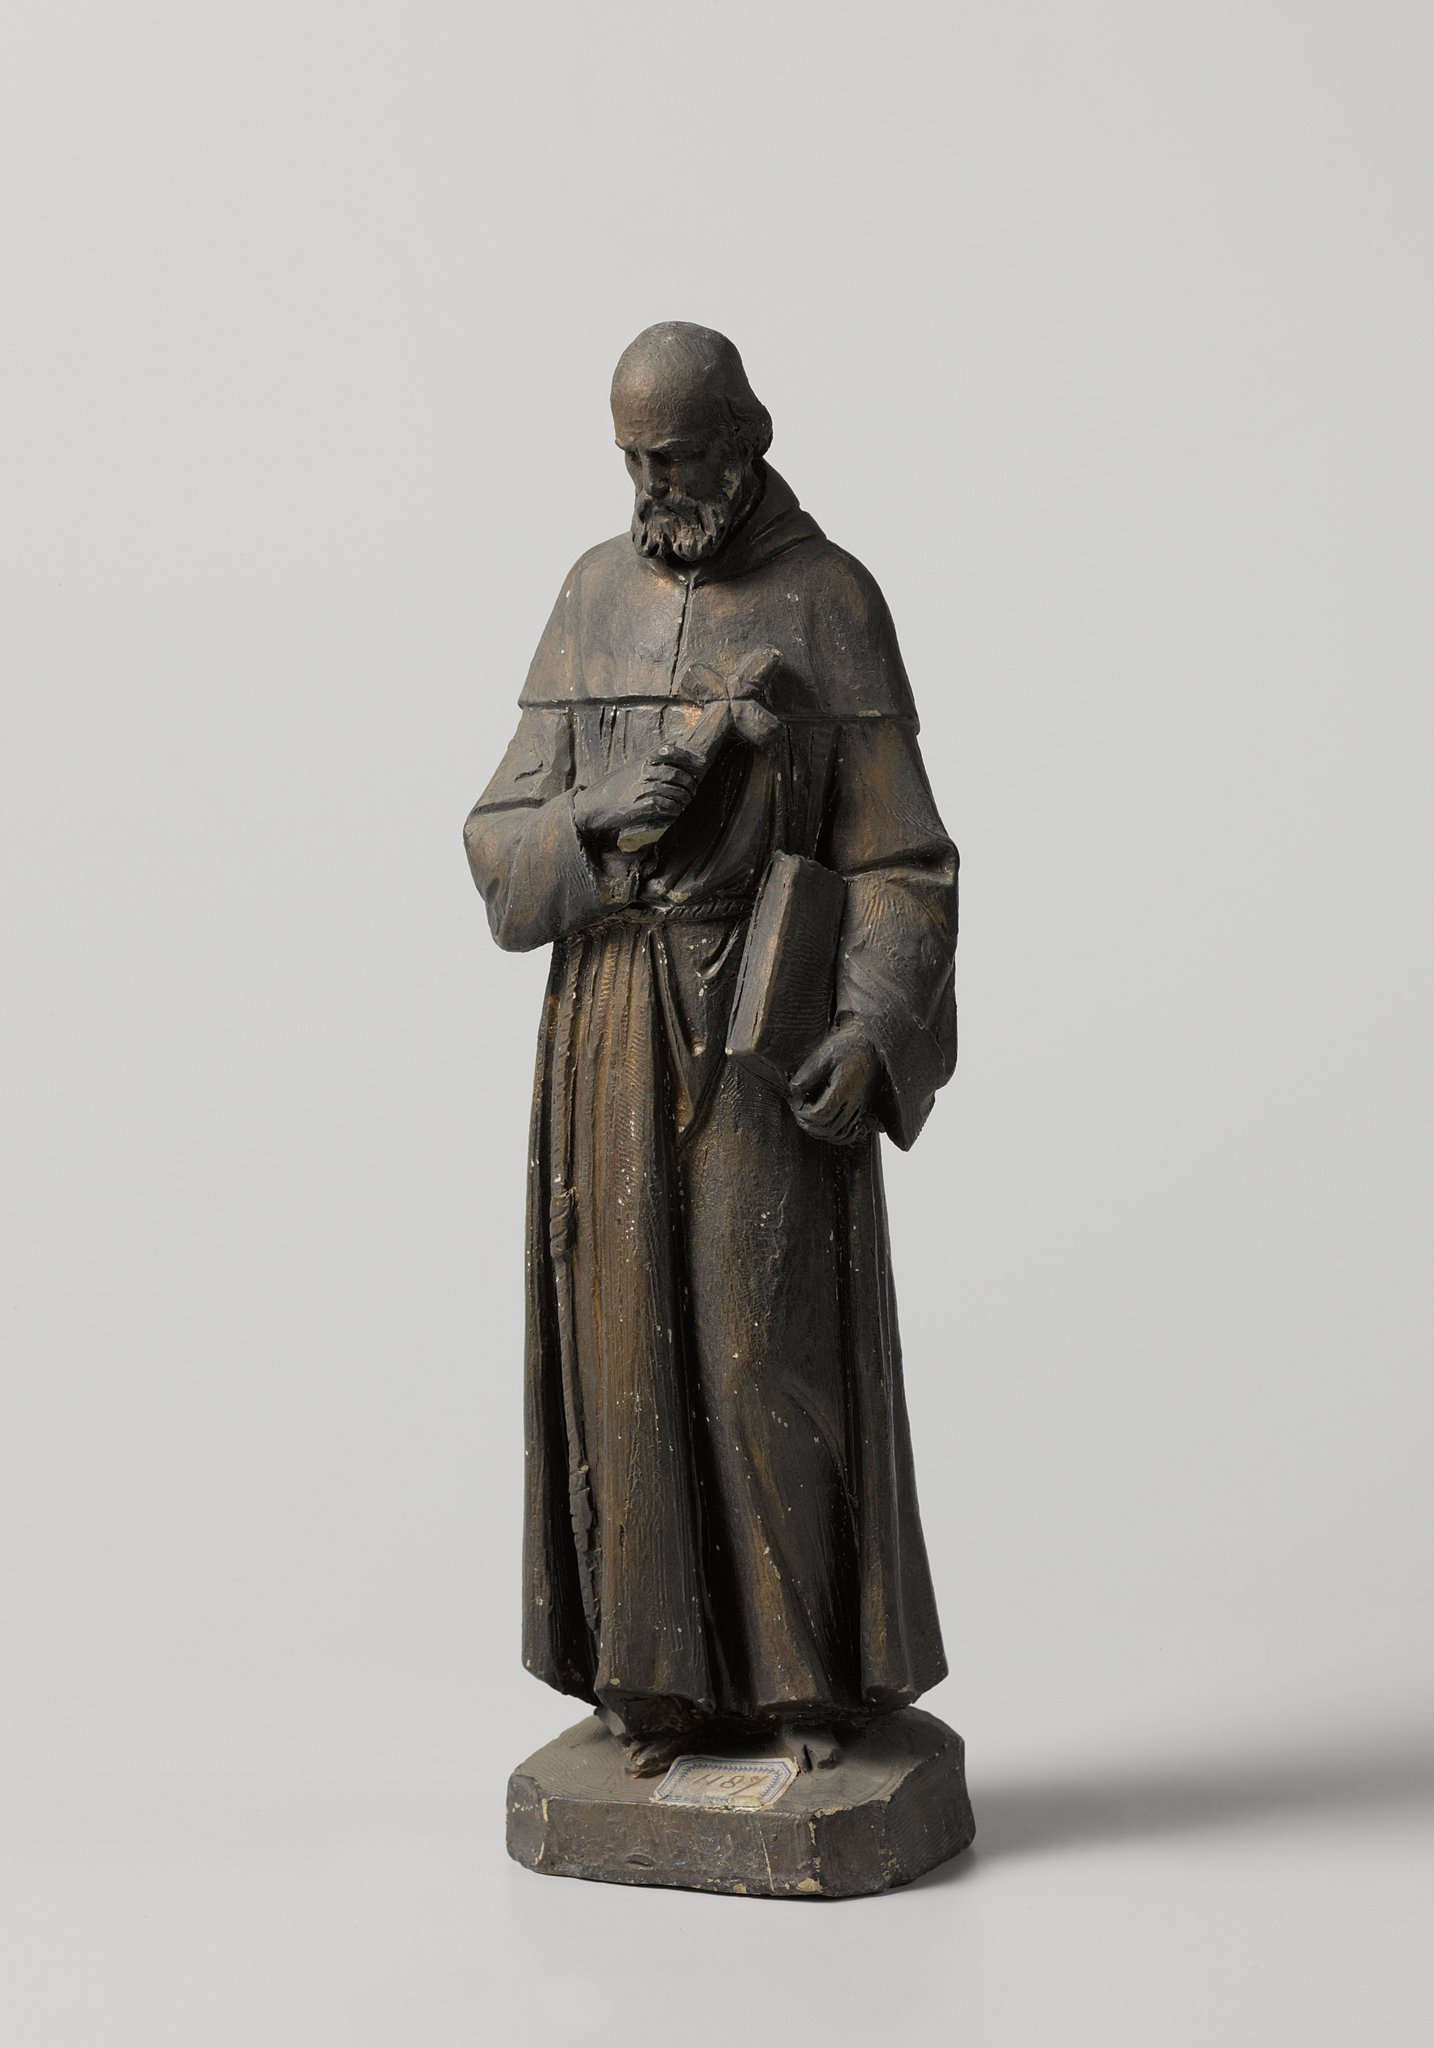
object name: sculpture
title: Monnik met kruis en boek (Willibrord?)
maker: eugène lacomblé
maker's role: draughtsman, painter, sculptor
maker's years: 1828-1905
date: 1800-1950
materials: terracotta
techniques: modeling